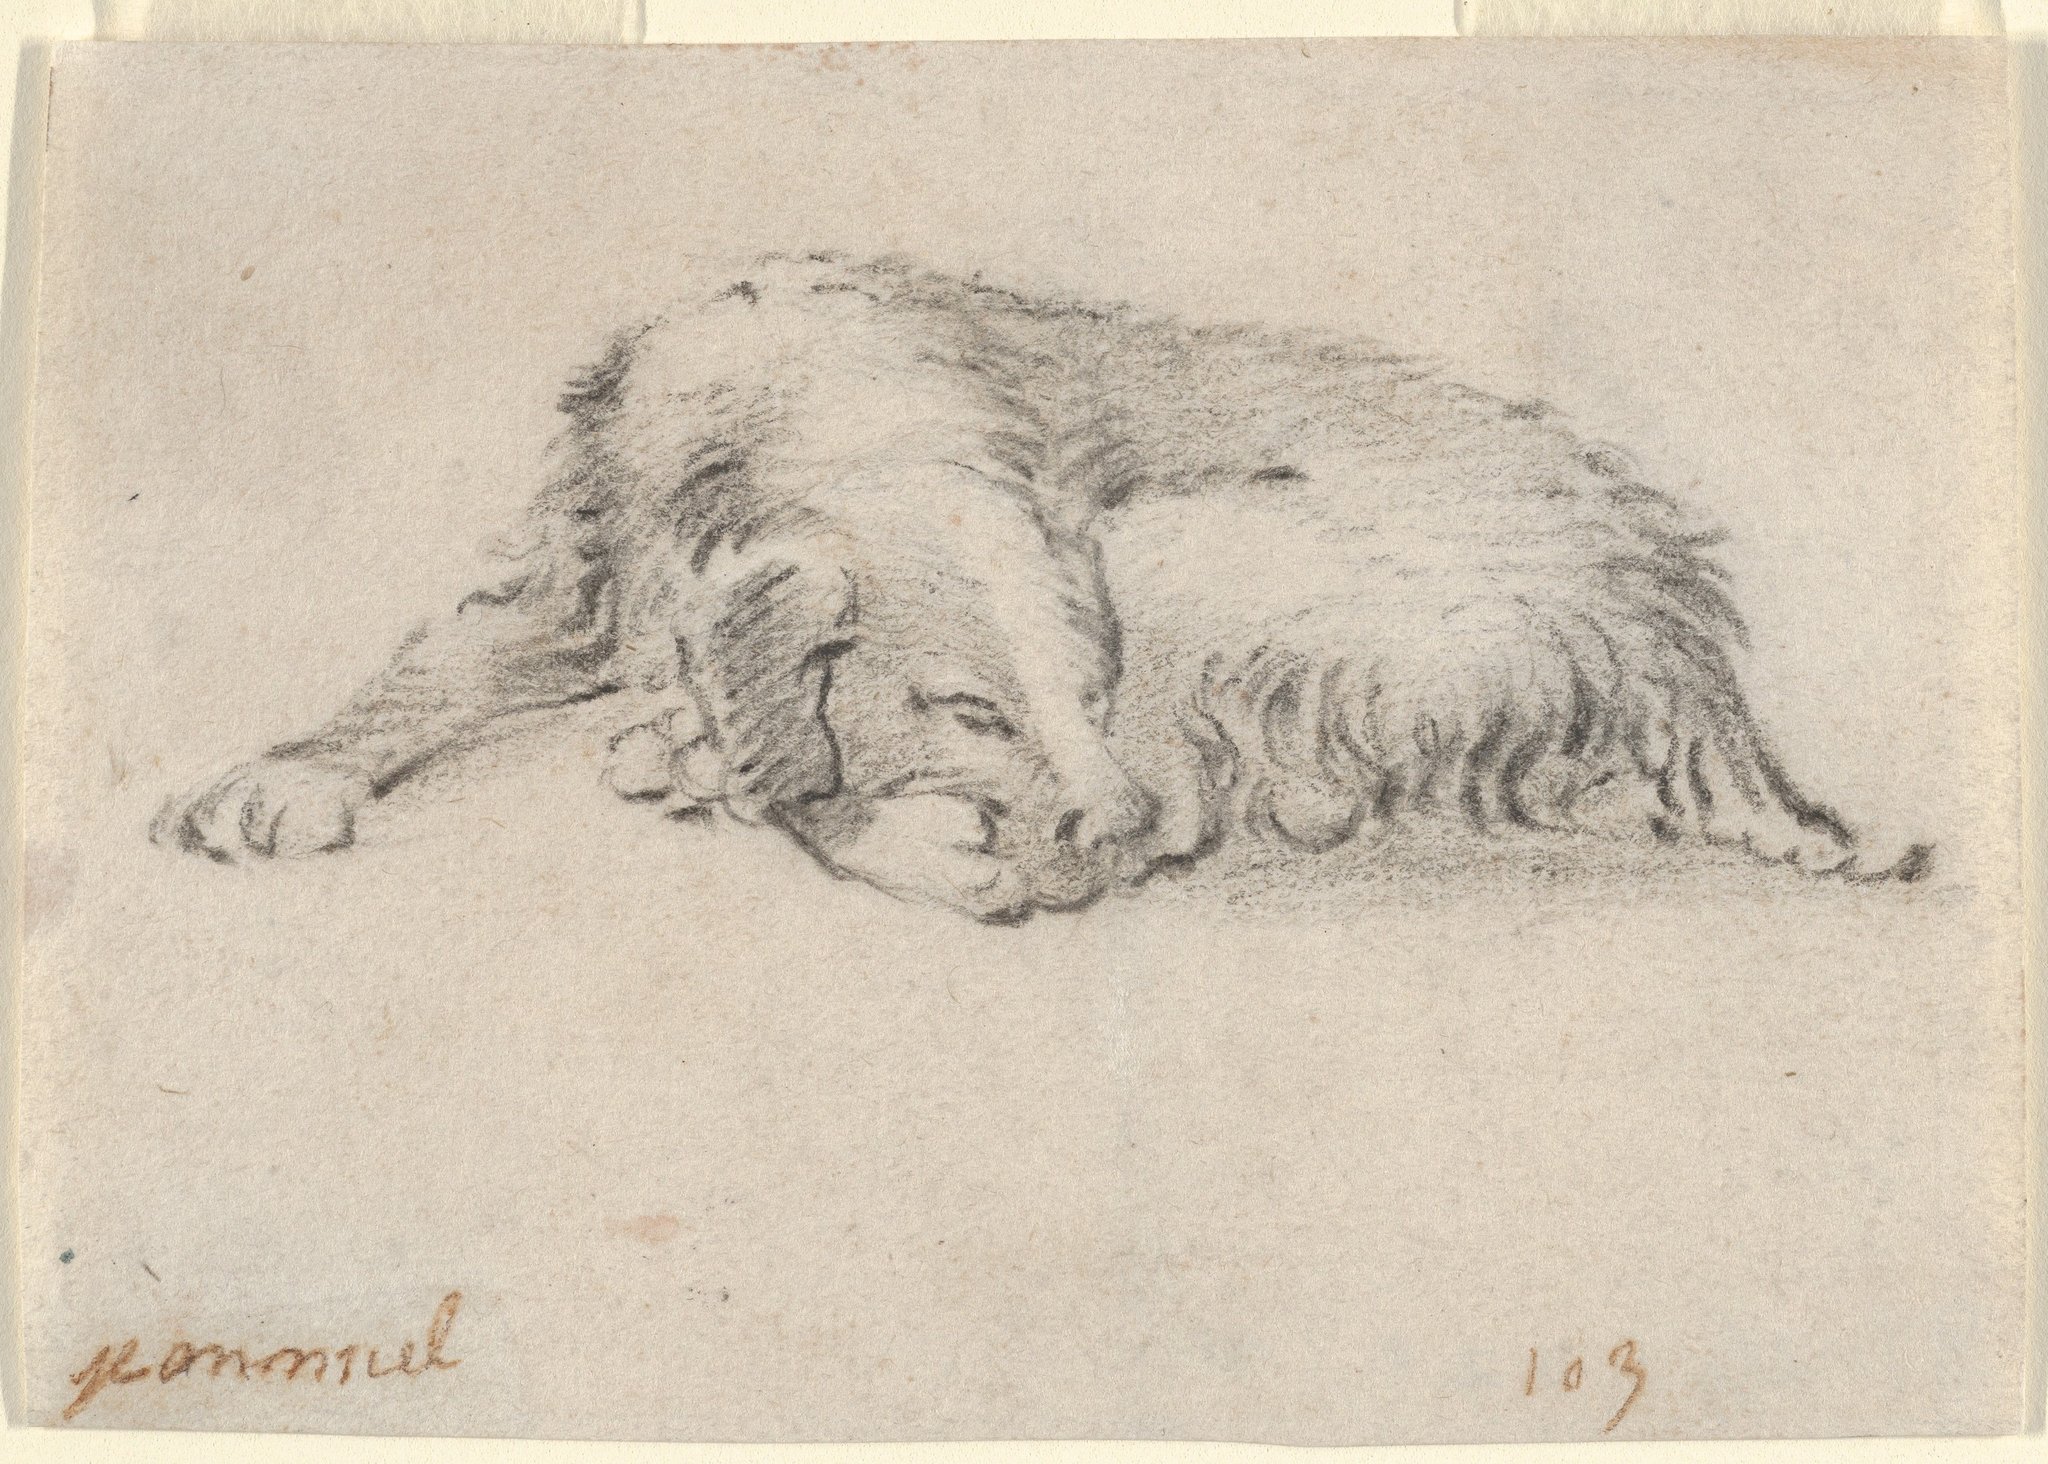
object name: drawing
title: Study of a Sleeping Dog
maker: jan miel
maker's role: artist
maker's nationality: flemish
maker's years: 1599-1664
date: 1634-1666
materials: chalk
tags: dogs